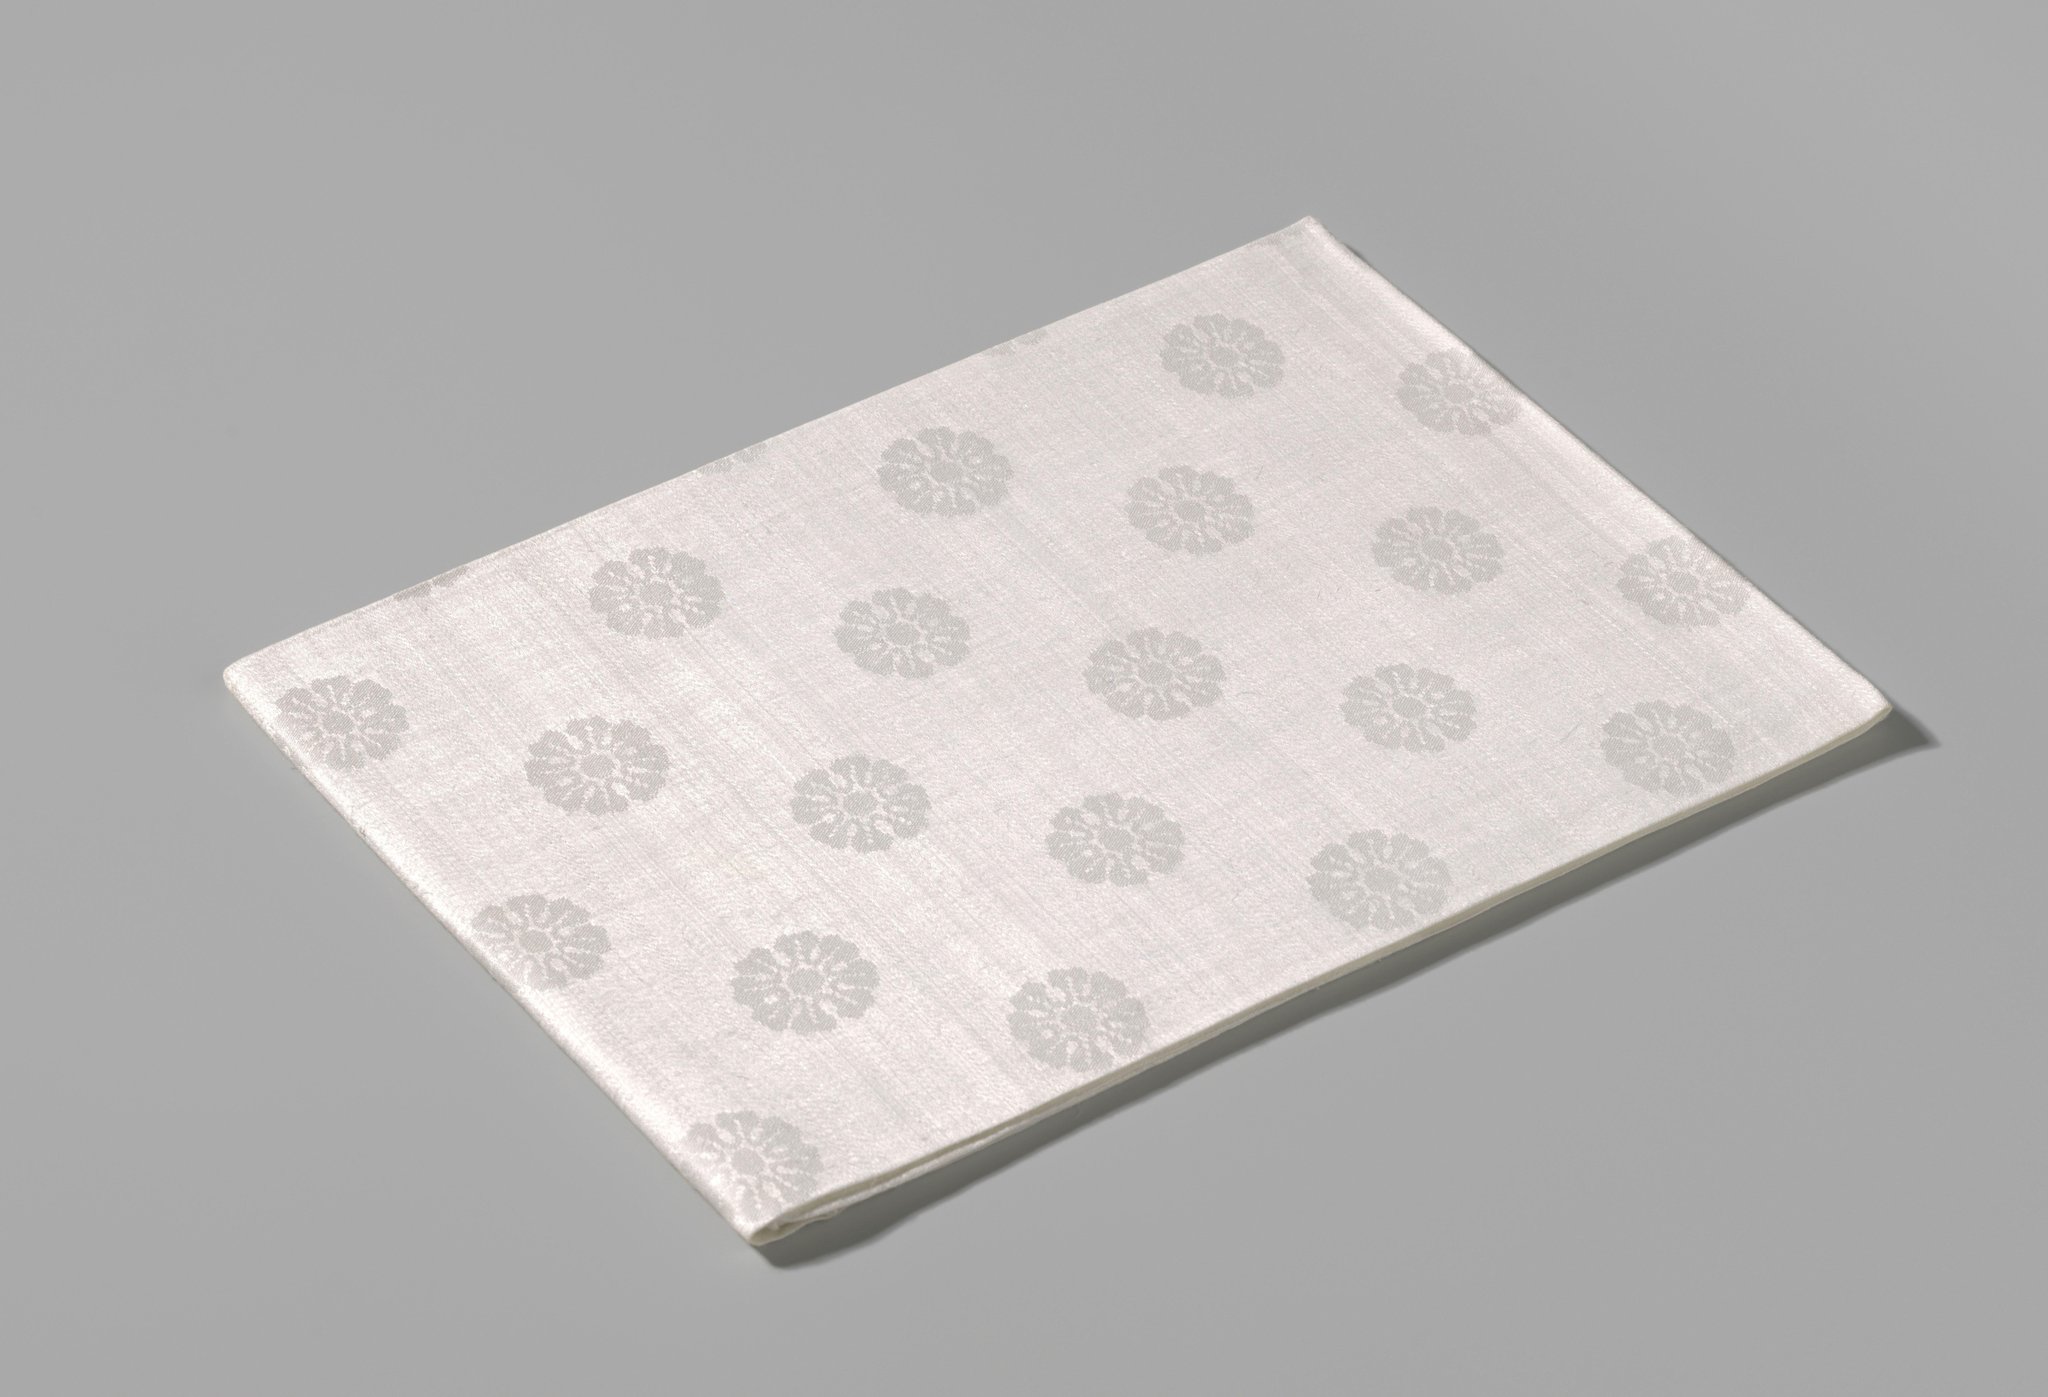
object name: napkin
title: Servet van linnendamast met een bloempatroon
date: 1849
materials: linen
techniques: damask, weave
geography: northern netherlands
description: Servet van linnendamast. Het veld heeft verspringende rijen rozetten en de hoeken hebben bloemen en acanthusbladeren. De hoeken hebben een vaas met vruchten. Het servet is gemerkt: HW36 1849. Het servet hoort bij dertien servetten (BK-1980-377-A t/m BK-1980-377-N).